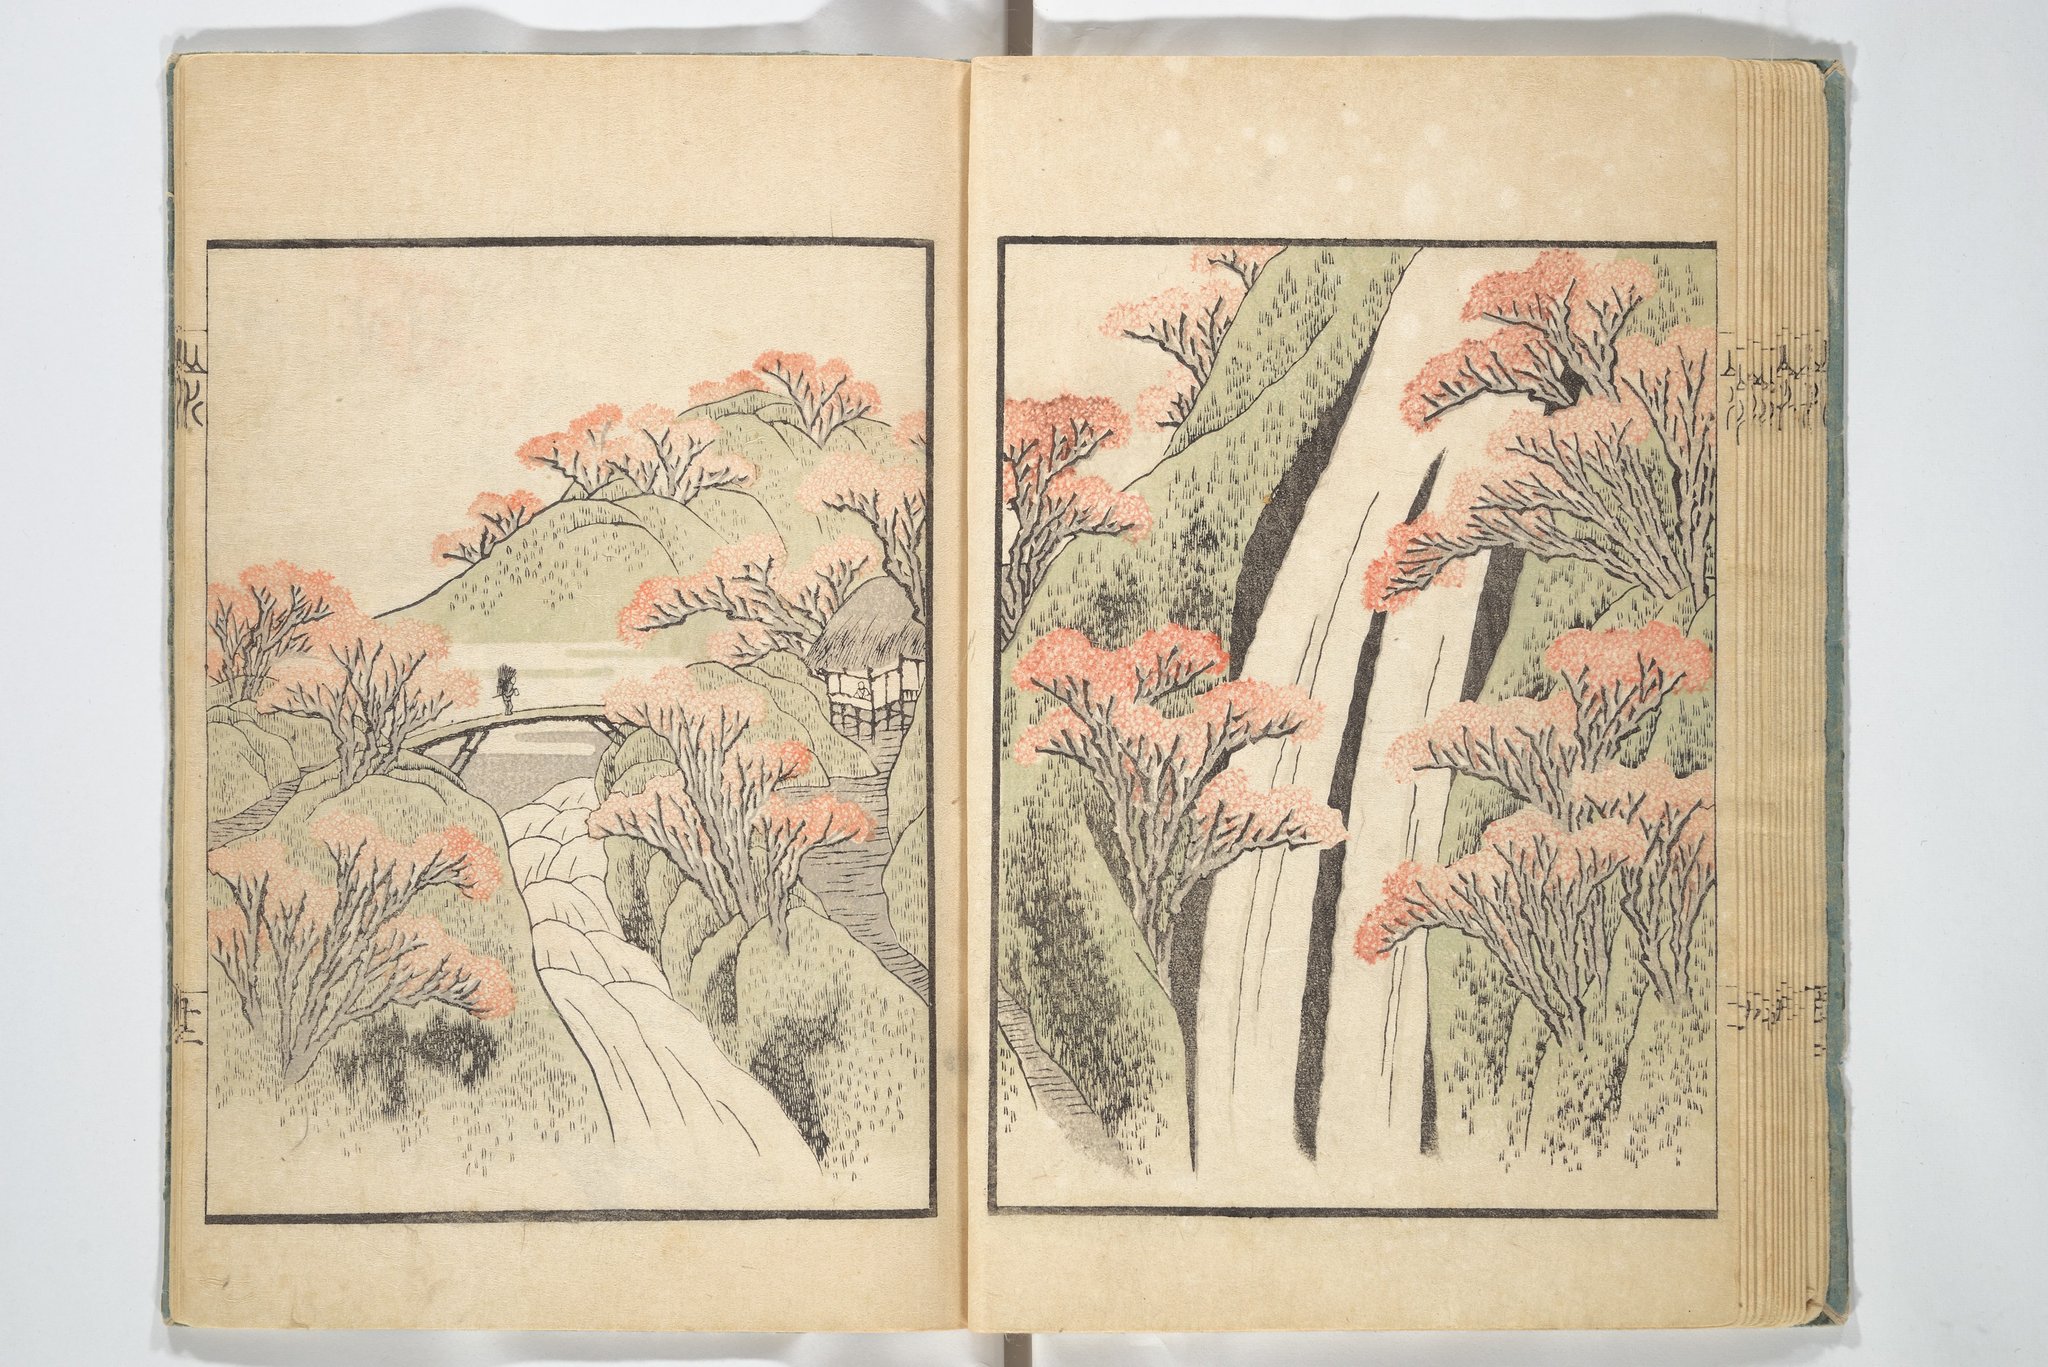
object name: illustrated book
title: Ichirō Picture Album (Ichirō gafu) 一老画譜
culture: japanese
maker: yashima gakutei 八島岳亭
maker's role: artist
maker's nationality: japanese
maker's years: 1786-1868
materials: ink, paper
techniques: woodblock print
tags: waterfalls,hills